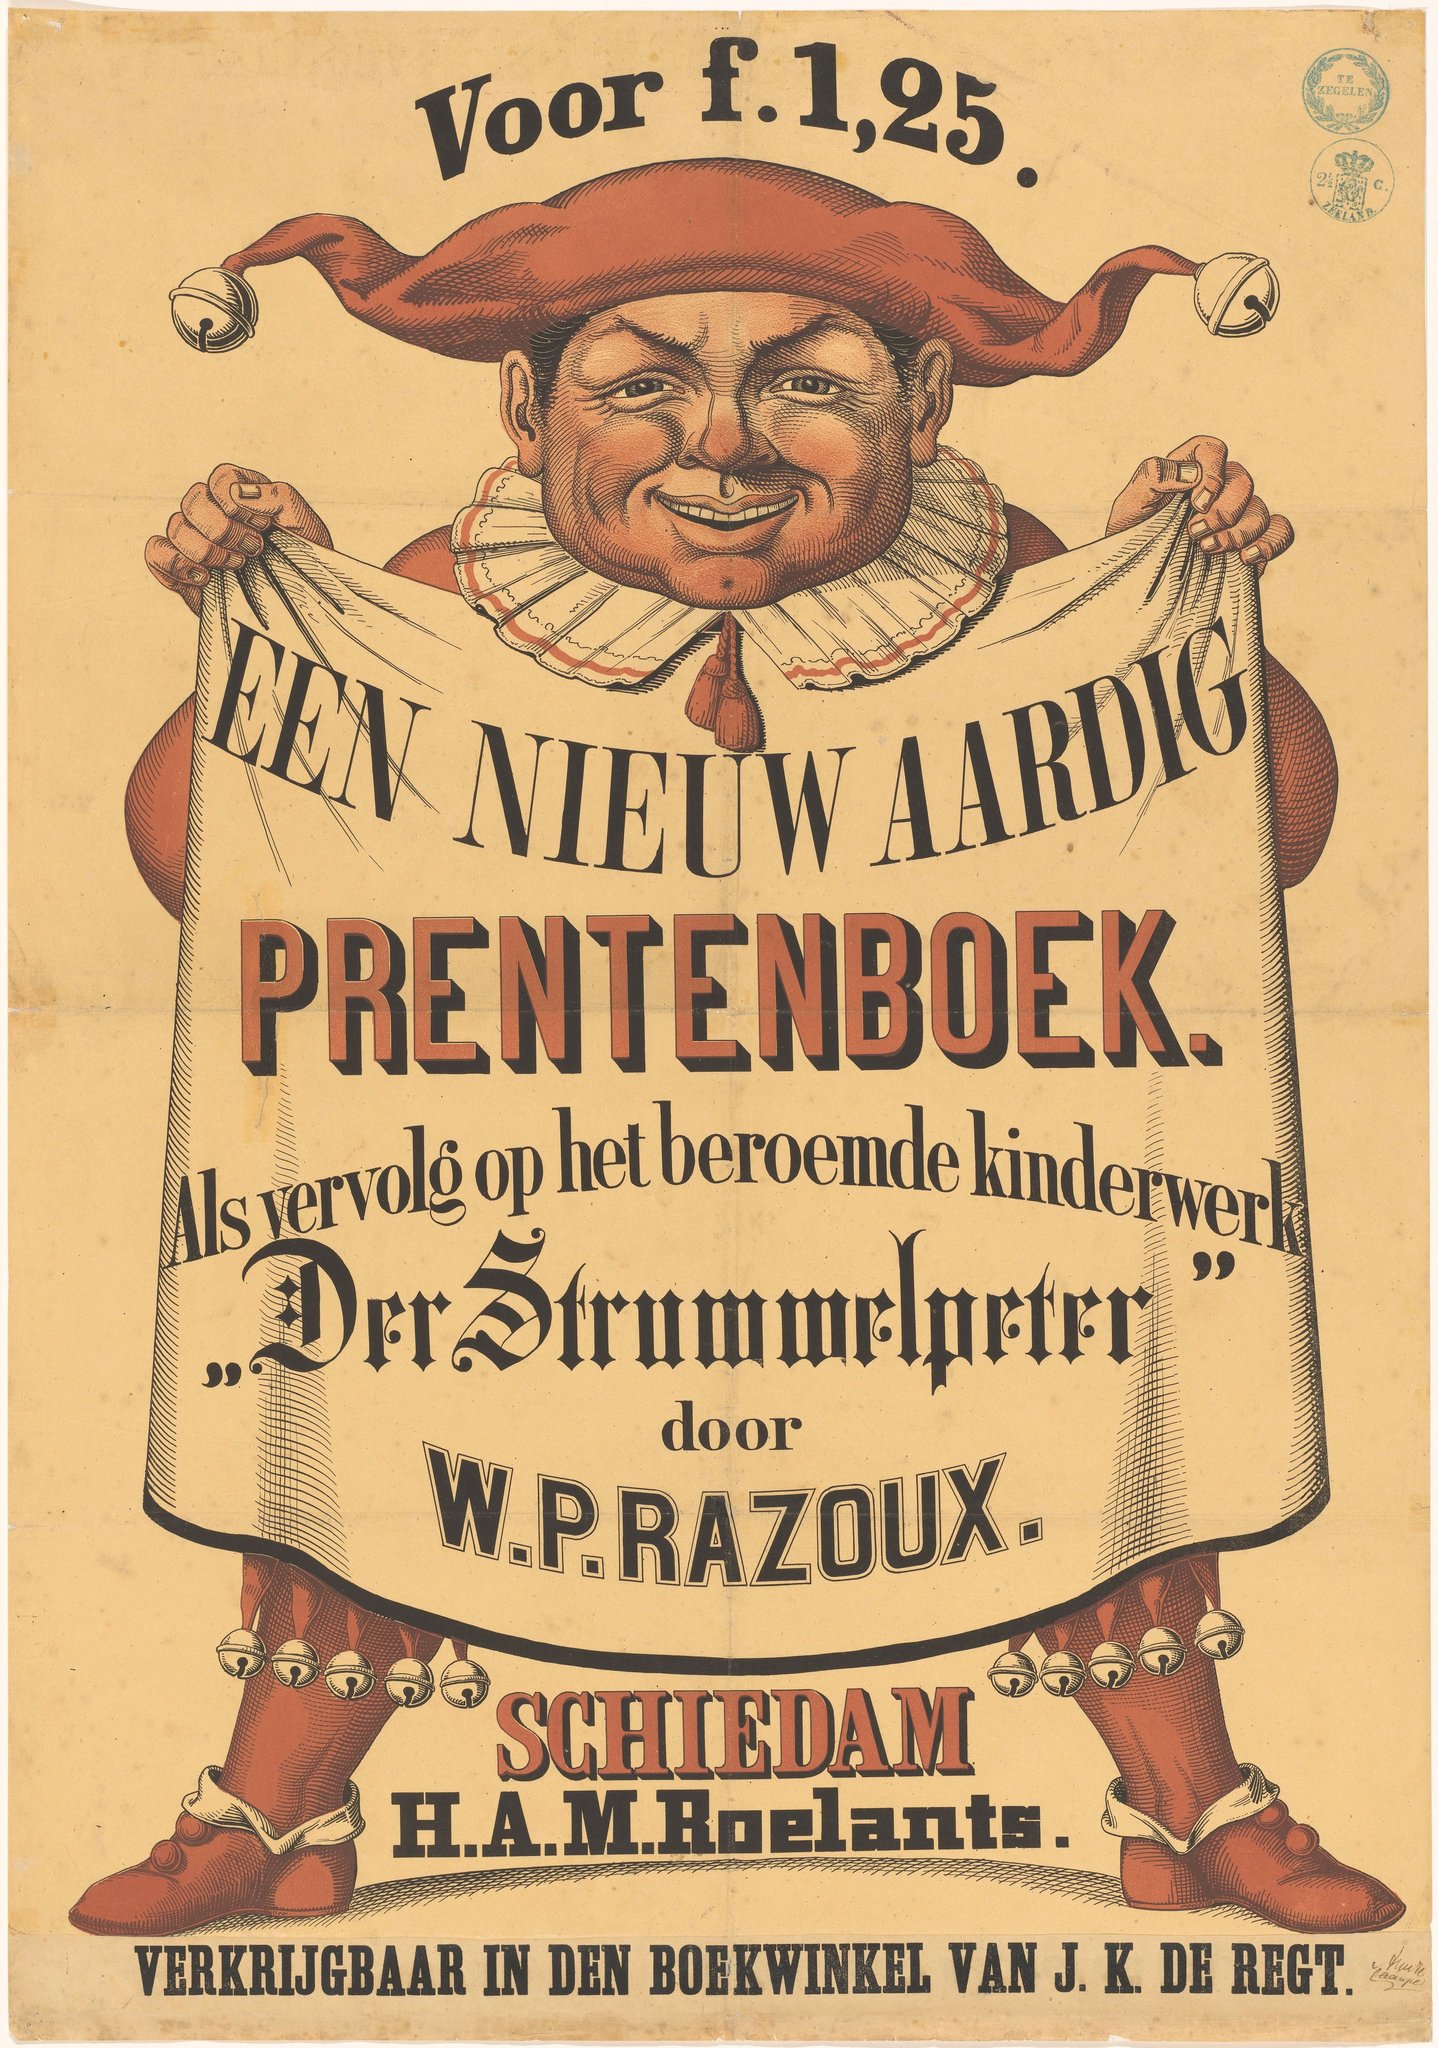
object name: poster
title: Affiche voor Een nieuw aardig prentenboek door Willem Paulus Razoux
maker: Anonymous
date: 1849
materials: paper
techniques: lithograph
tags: court jester, court fool, fool's cap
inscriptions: collector's mark: Lugt 2228, inscription, stamp: ‘2 1/2 C Zeeland’, collector's mark: Lugt 4779, stamp: ‘Te zegelen’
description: Onder de afbeelding is een strook geplakt met daarop de mededeling dat het boek verkrijgbaar is bij boekhandel J.K. de Regt, werkzaam in Middelburg tussen 1850-1854. Reclame voor: Razoux, Willem Paulus. Een aardig prentenboek. Schiedam: H.A.M. Roelants, [1849]. Het betreft een bewerking van de verhalen over 'Struwelpeter' door Heinrich Hoffmann, oorspronkelijk verschenen in het Duits.